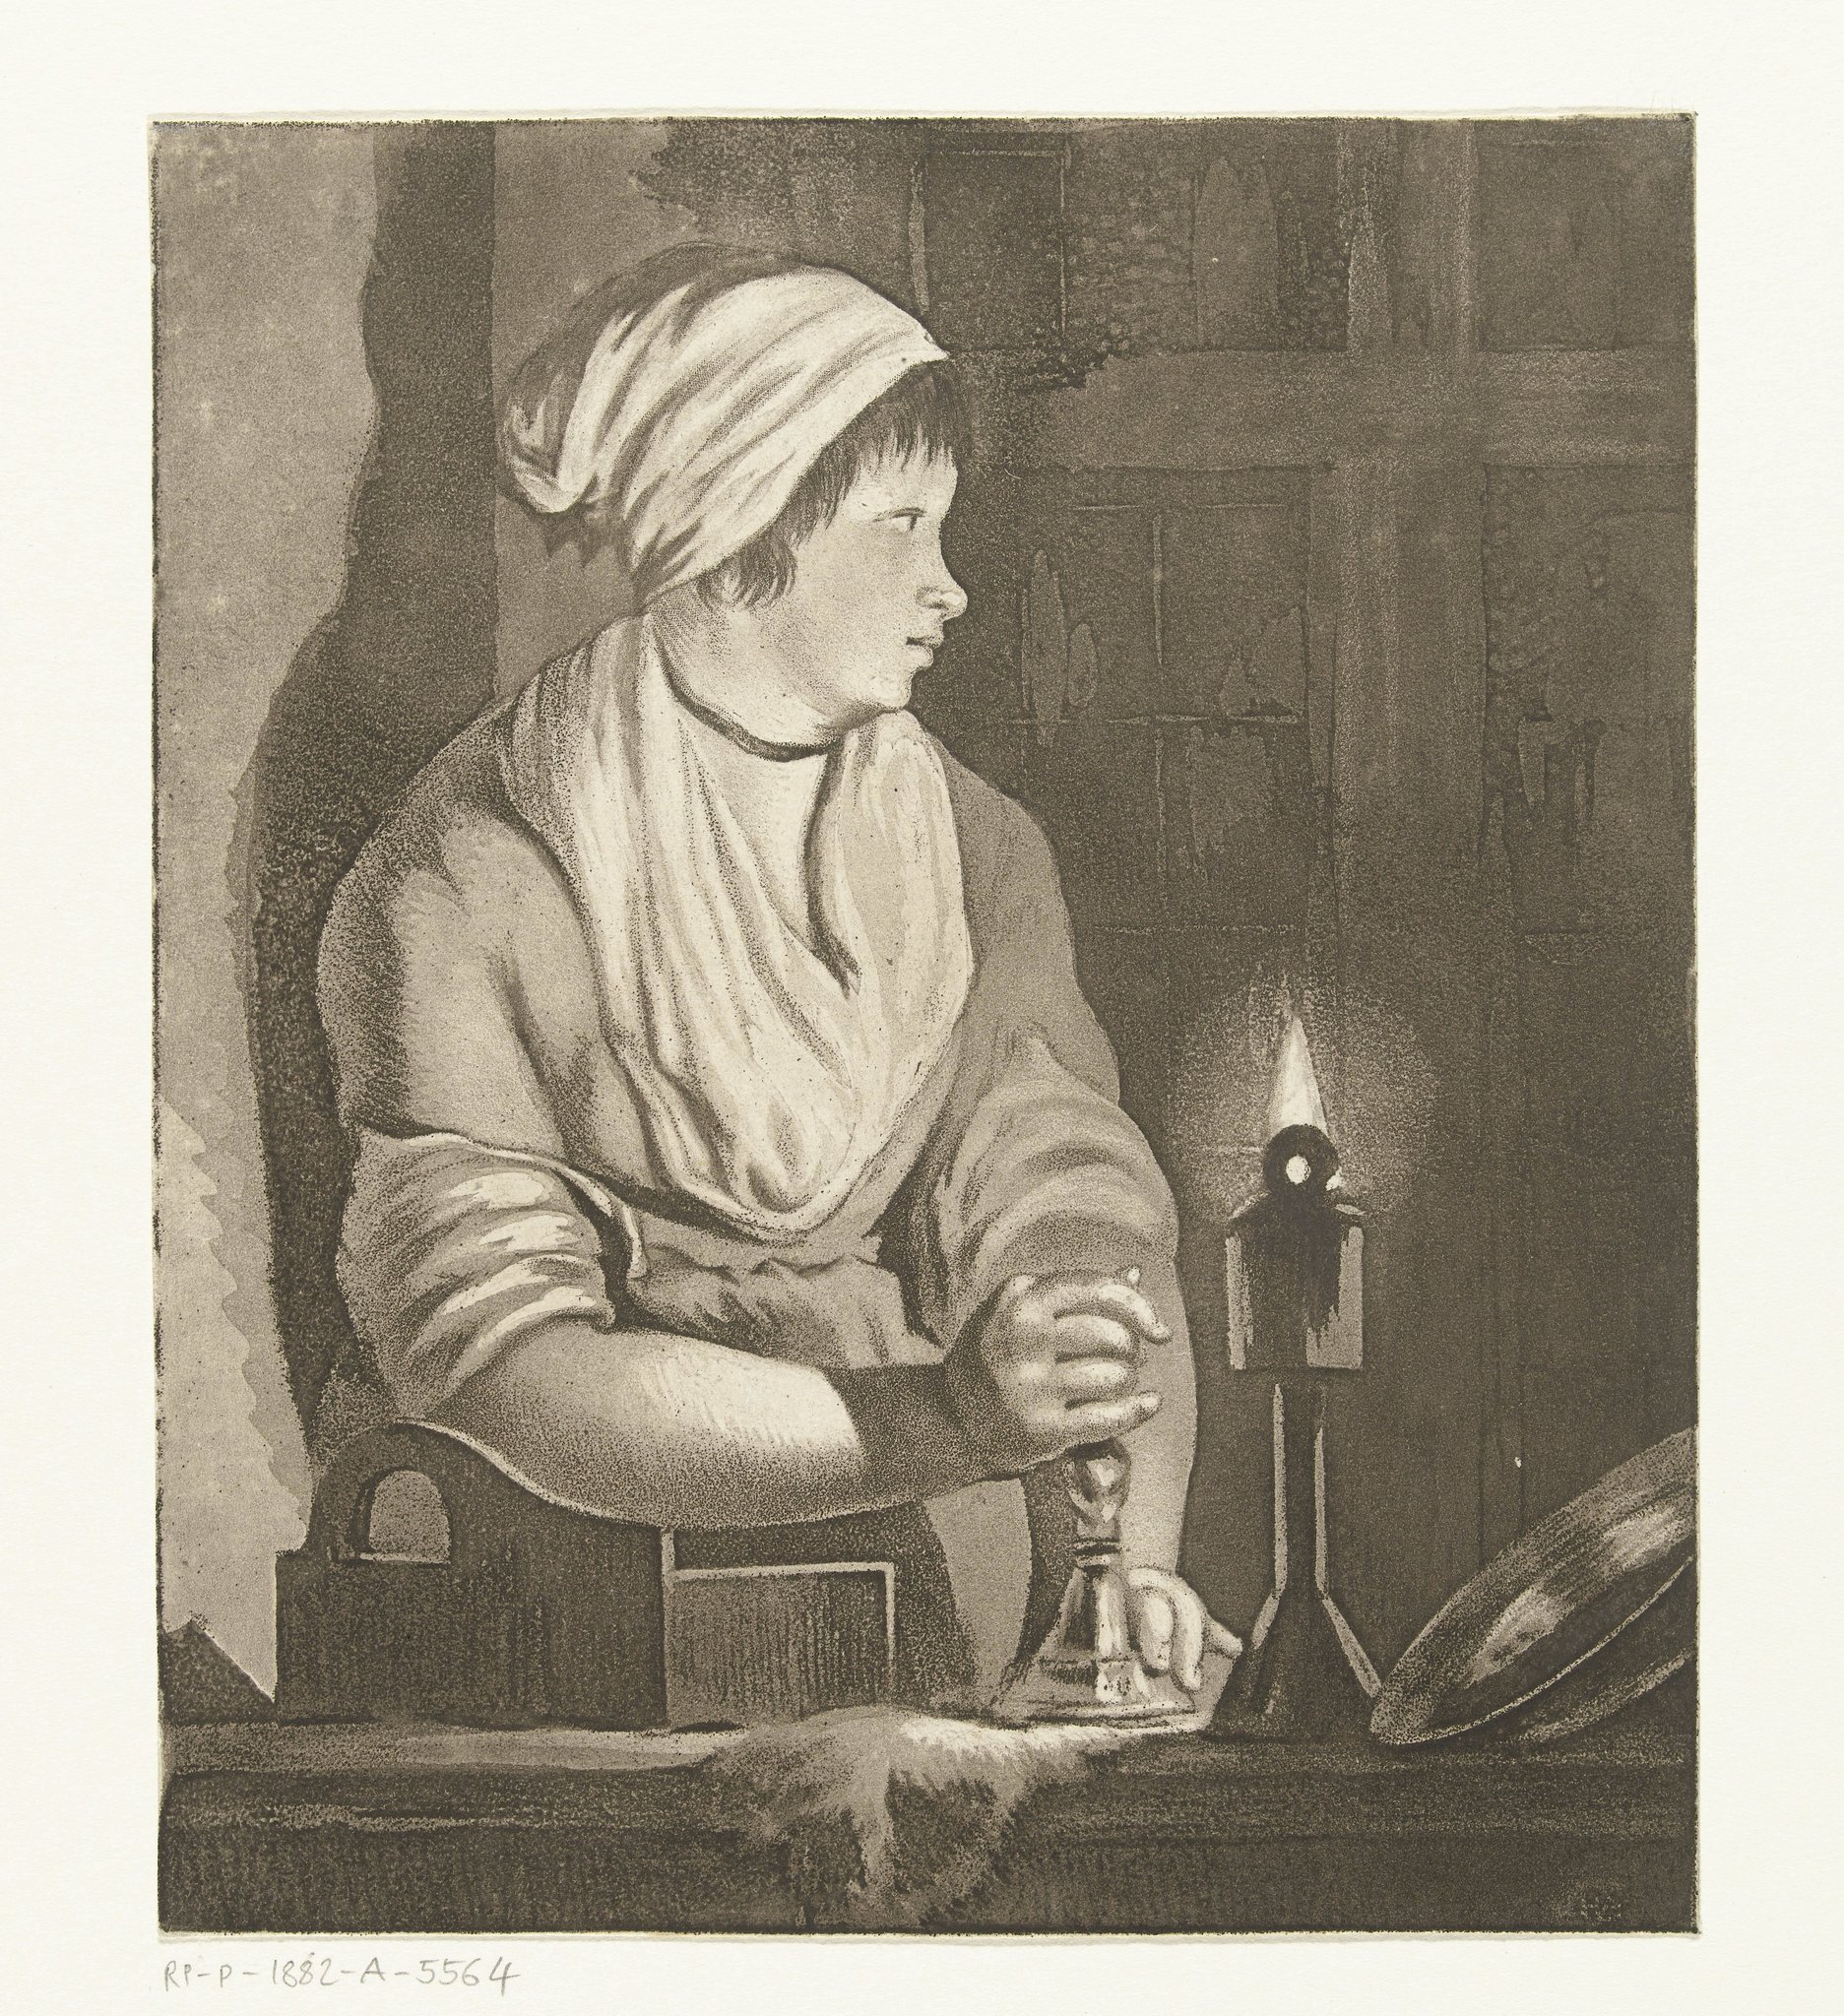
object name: print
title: Dienstmeid met kandelaar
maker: hermanus van brussel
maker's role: draughtsman, print maker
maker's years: 1763-1815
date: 1778-1815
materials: paper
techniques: aquatint, printmaking, etching, roulette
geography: netherlands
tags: chandelier, candelabrum, maid ~ house personnel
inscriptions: collector's mark: Lugt 2228